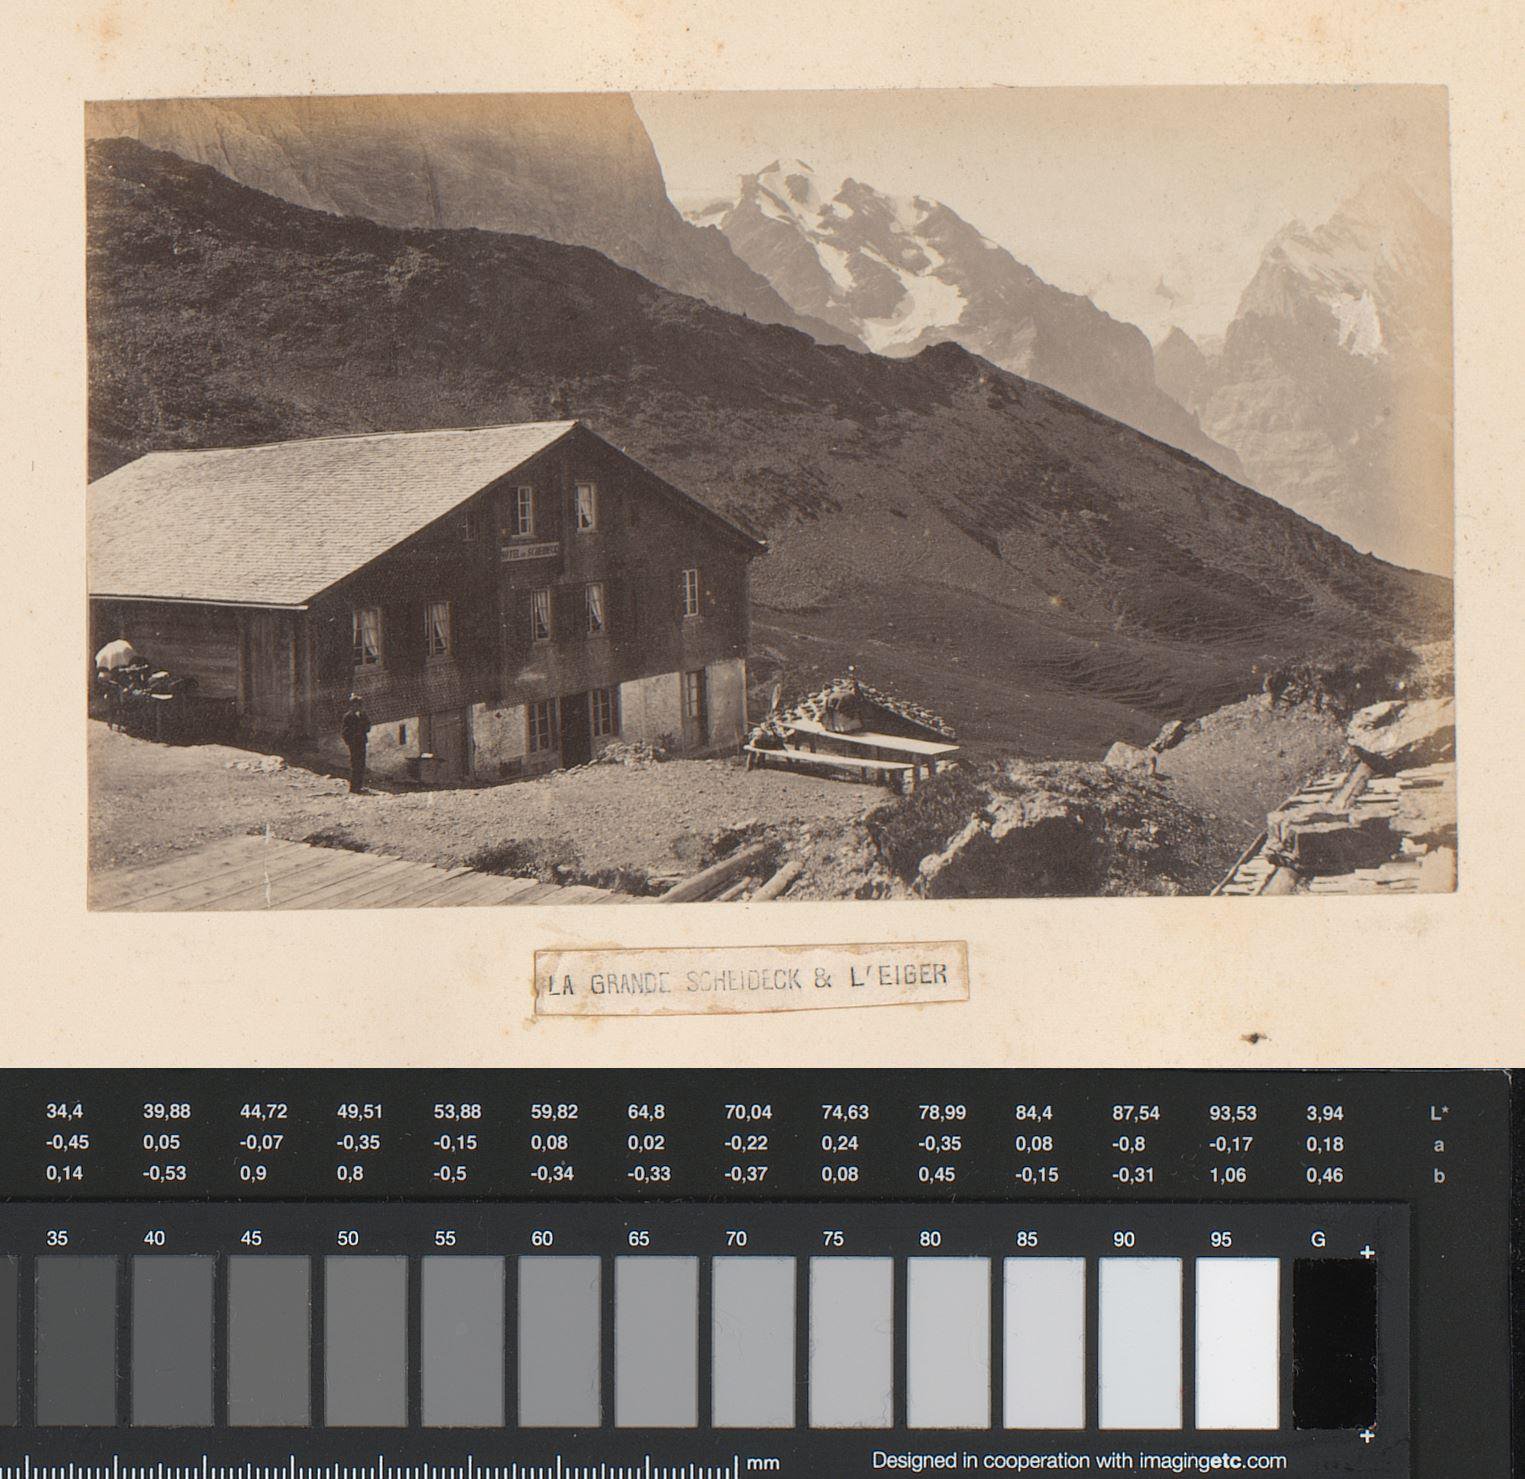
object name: album leaf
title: Gezicht op de Grosse Scheidegg en de Eiger, Zwitserland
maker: Anonymous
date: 1860-1890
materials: paper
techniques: albumen print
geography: grote scheidegg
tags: farm or solitary house in landscape, mountains